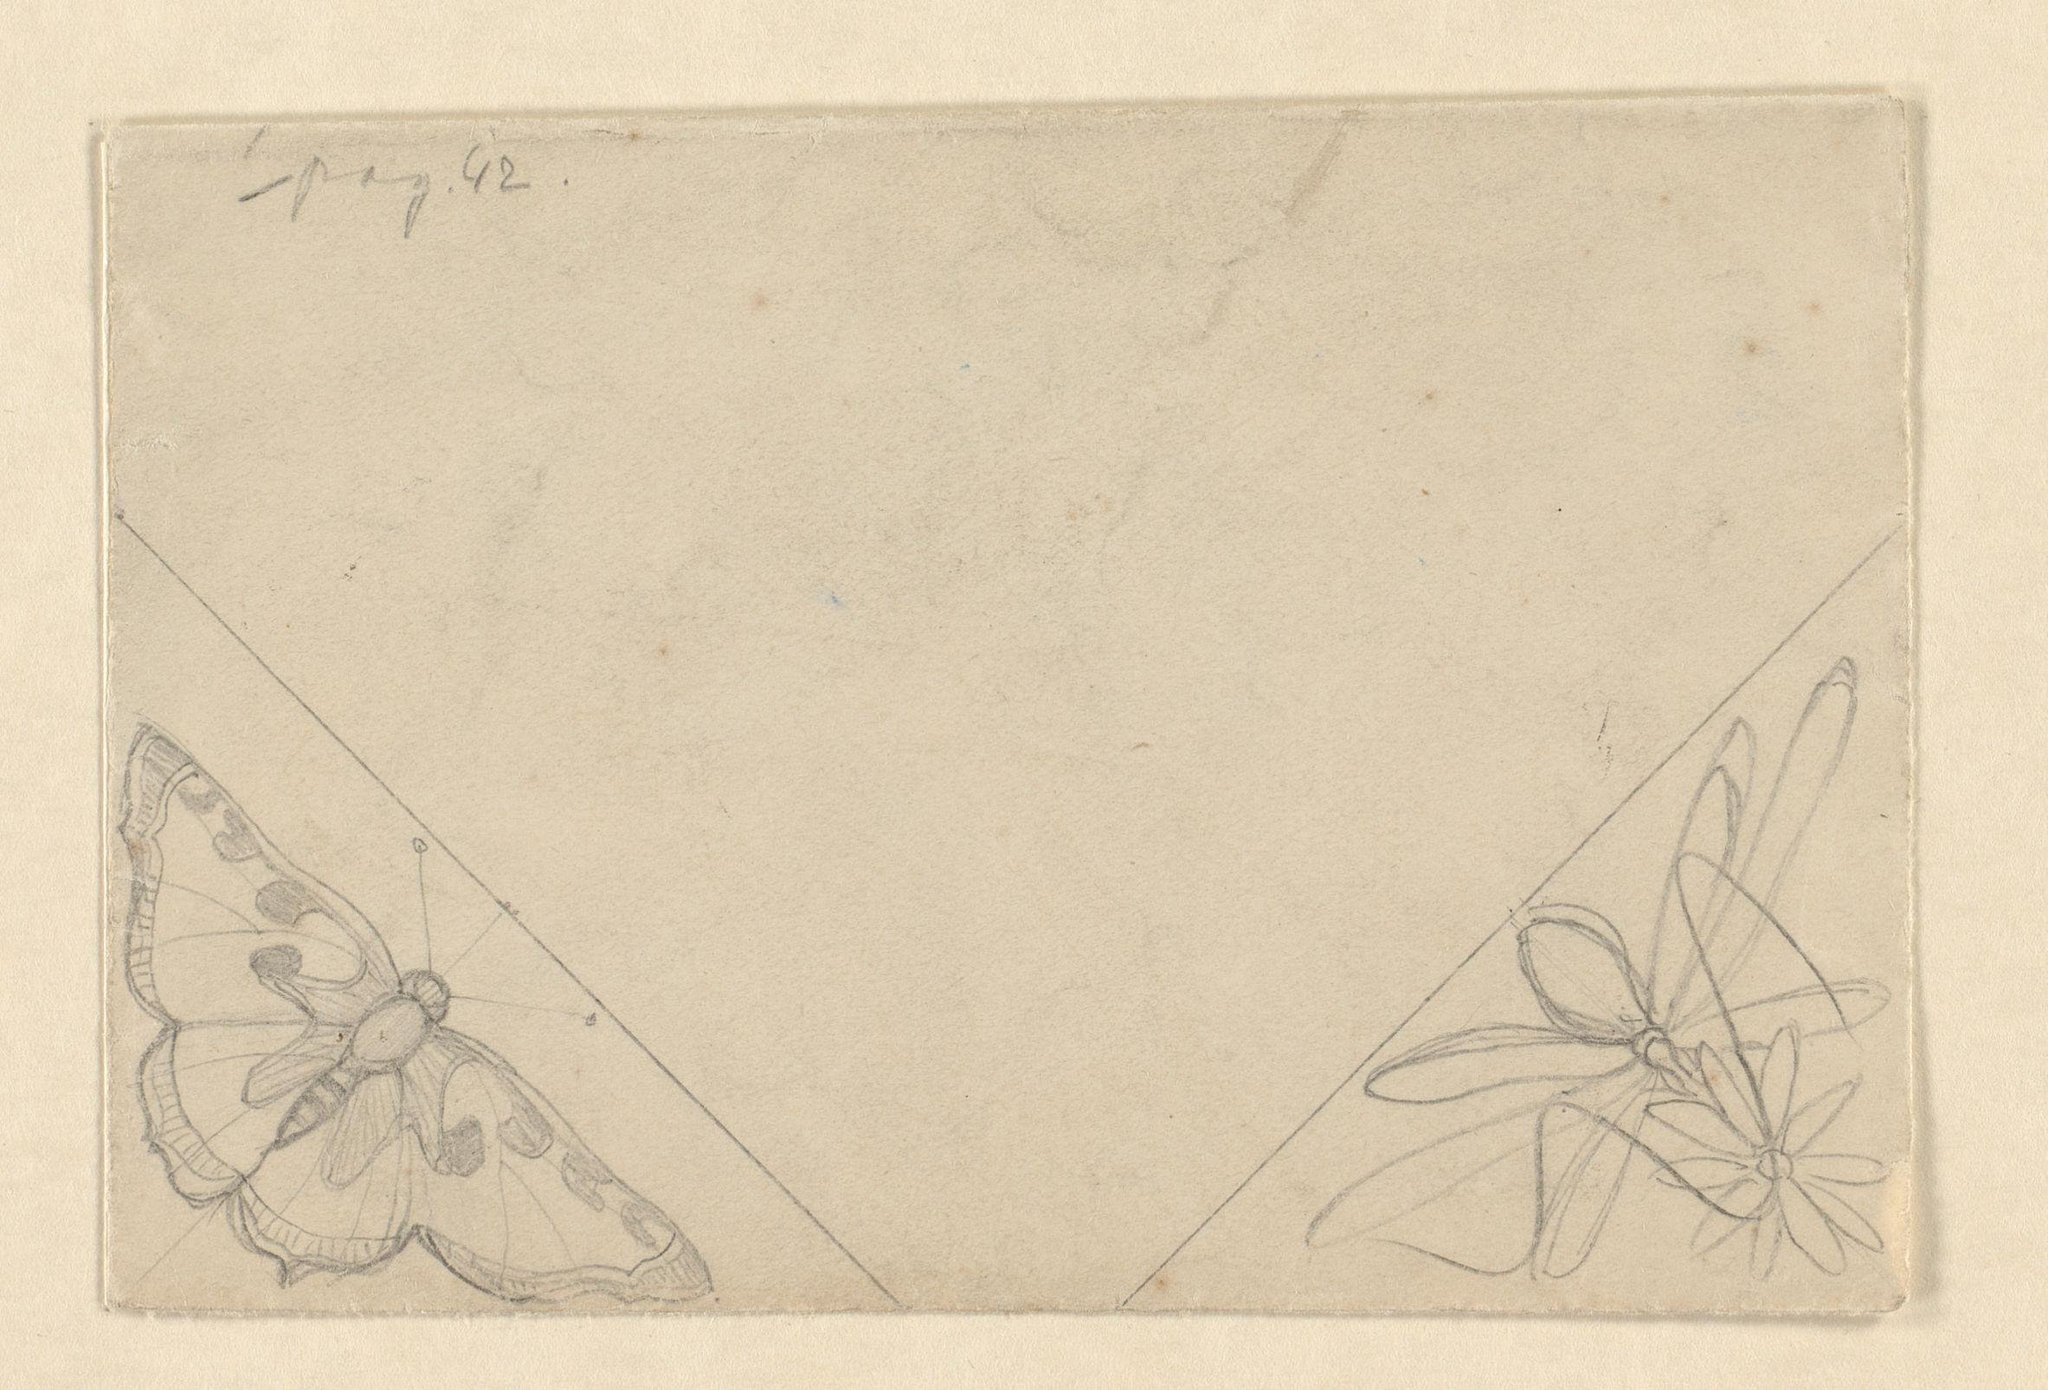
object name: drawing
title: Vlinders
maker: edzard koning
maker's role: draughtsman, print maker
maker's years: 1869-1954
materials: paper, pencil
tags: (van eeden, de kleine johannes) specific works of literature (with author, title), insects: butterfly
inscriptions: collector's mark: Lugt 2228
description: Waarschijnlijk een ontwerp voor de hoeken van de band voor: Eeden, Frederik van. De kleine Johannes. Den Haag: Mouton & Co., 1898.